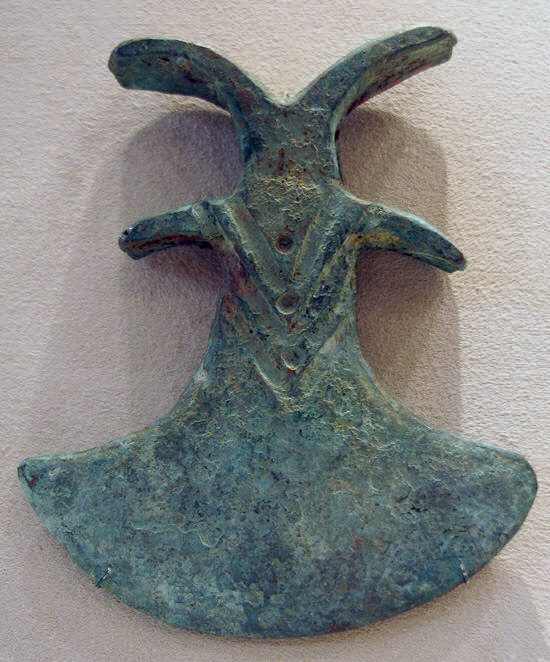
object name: ax blade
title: Celt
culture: indonesian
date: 500 BCE-300 CE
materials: bronze